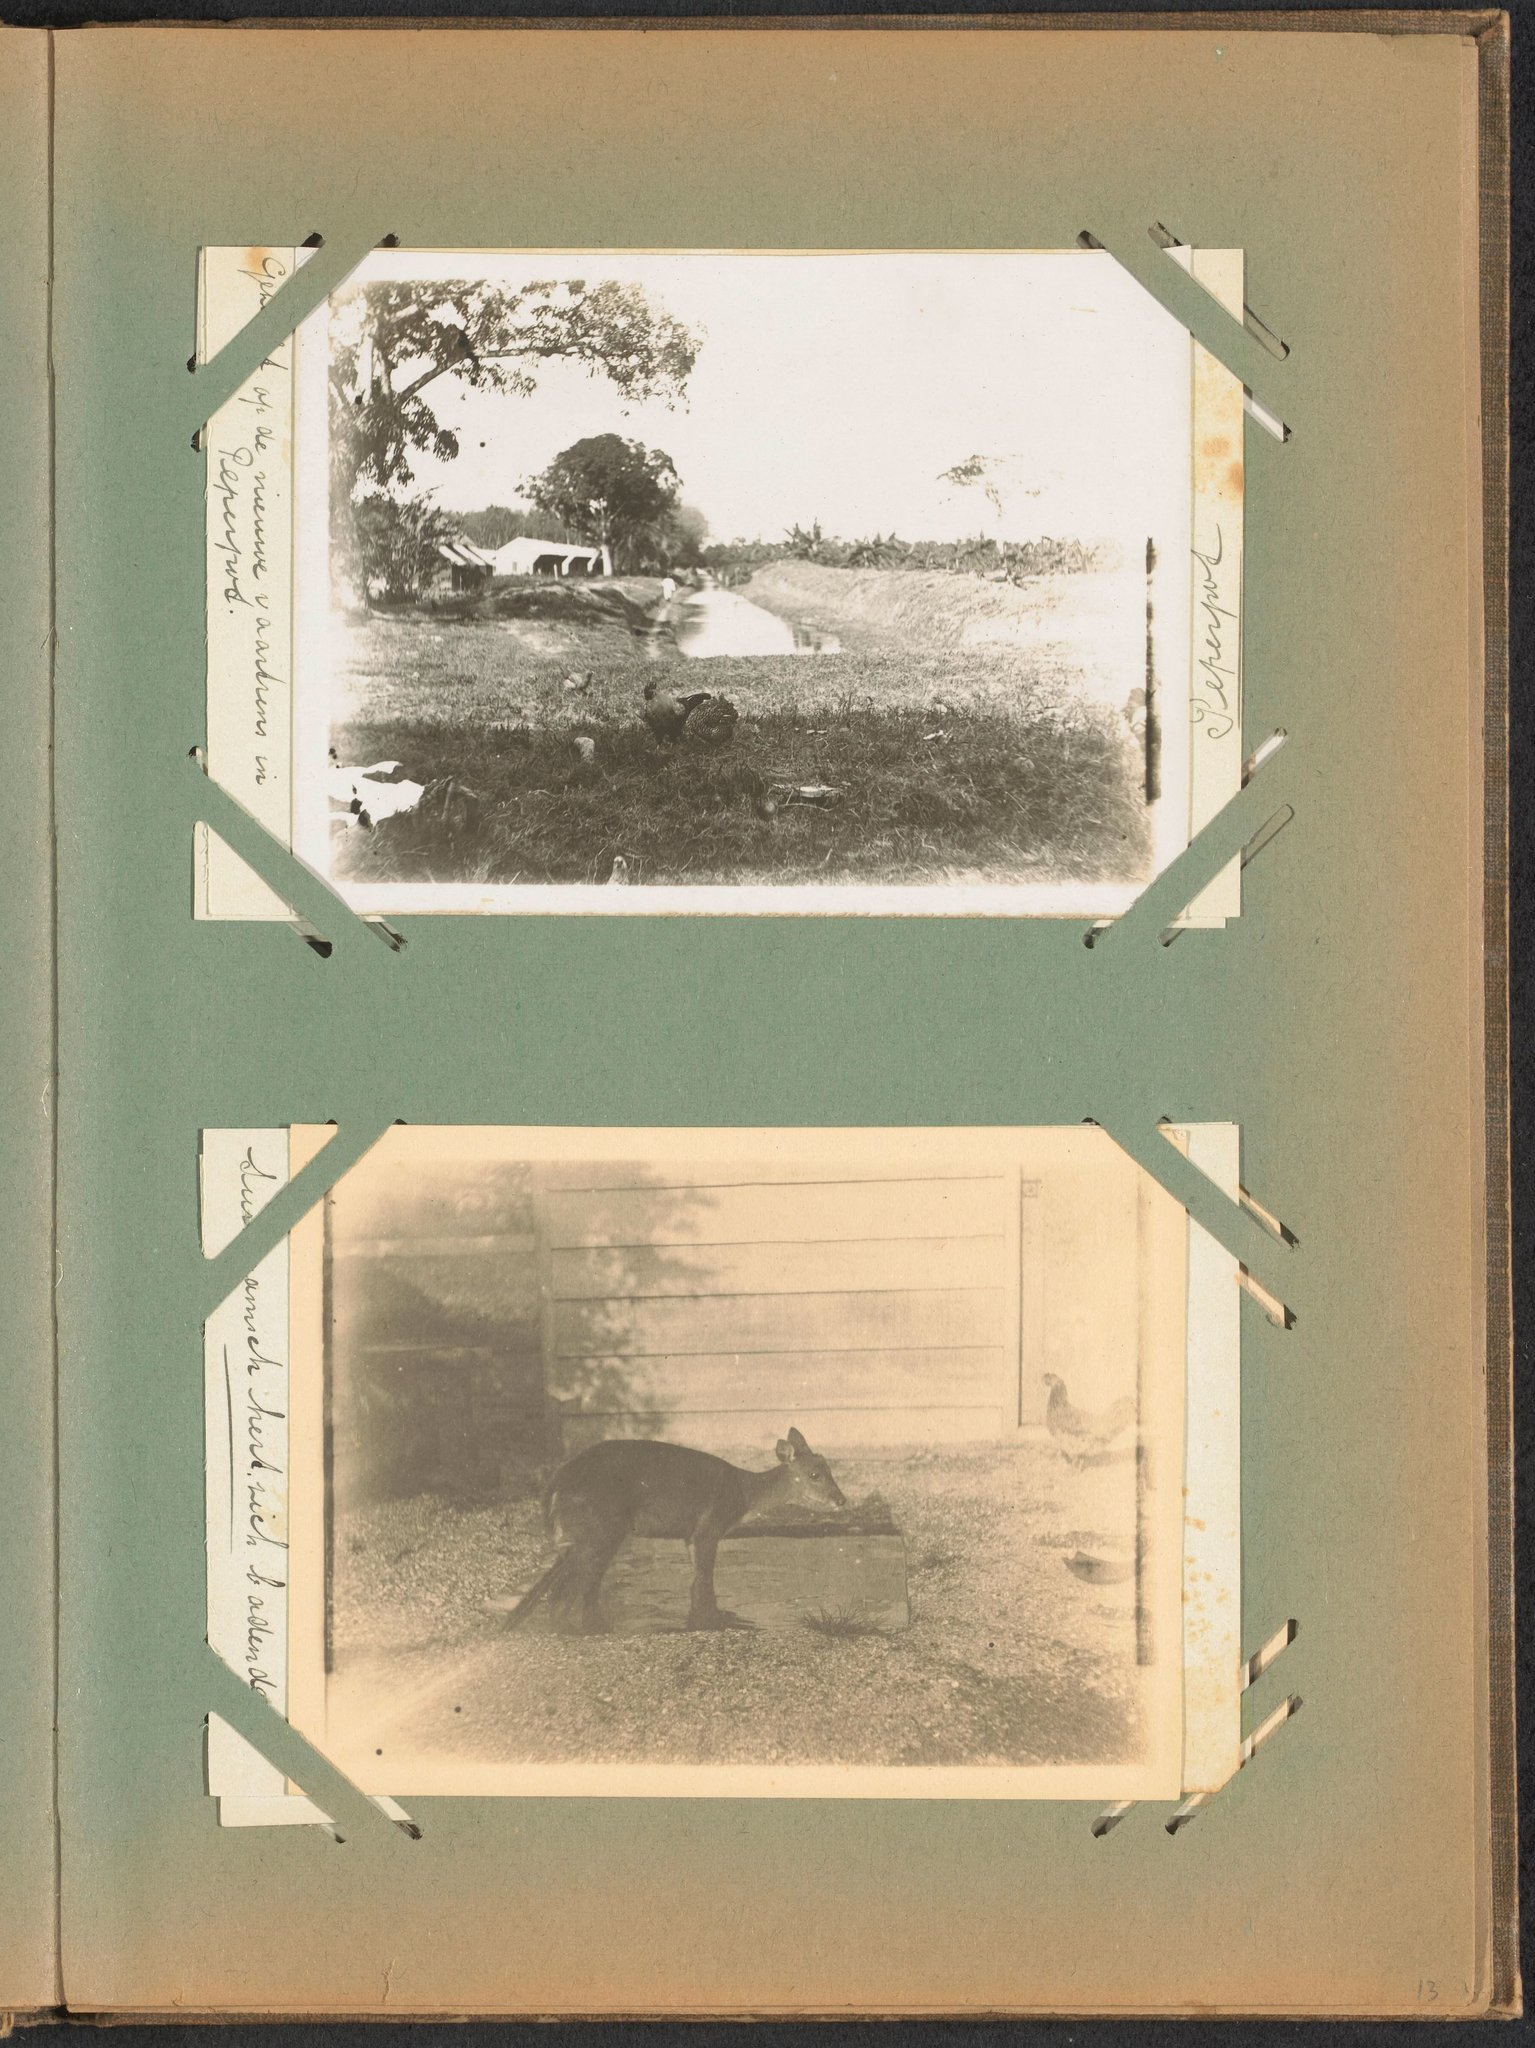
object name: photograph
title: Gezicht op de nieuwe vaartrens in Peperpot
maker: Anonymous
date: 1912-1913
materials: paper, photographic support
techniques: gelatin silver print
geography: suriname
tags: plantation, suriname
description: De nieuwe vaartrens in Plantage Peperpot in Suriname. Onderdeel van het fotoalbum uit ca. 1912-1913 met 92 foto's van de plantages Peperpot en Dordrecht in Suriname en Mount Pleasant op Curaçao.